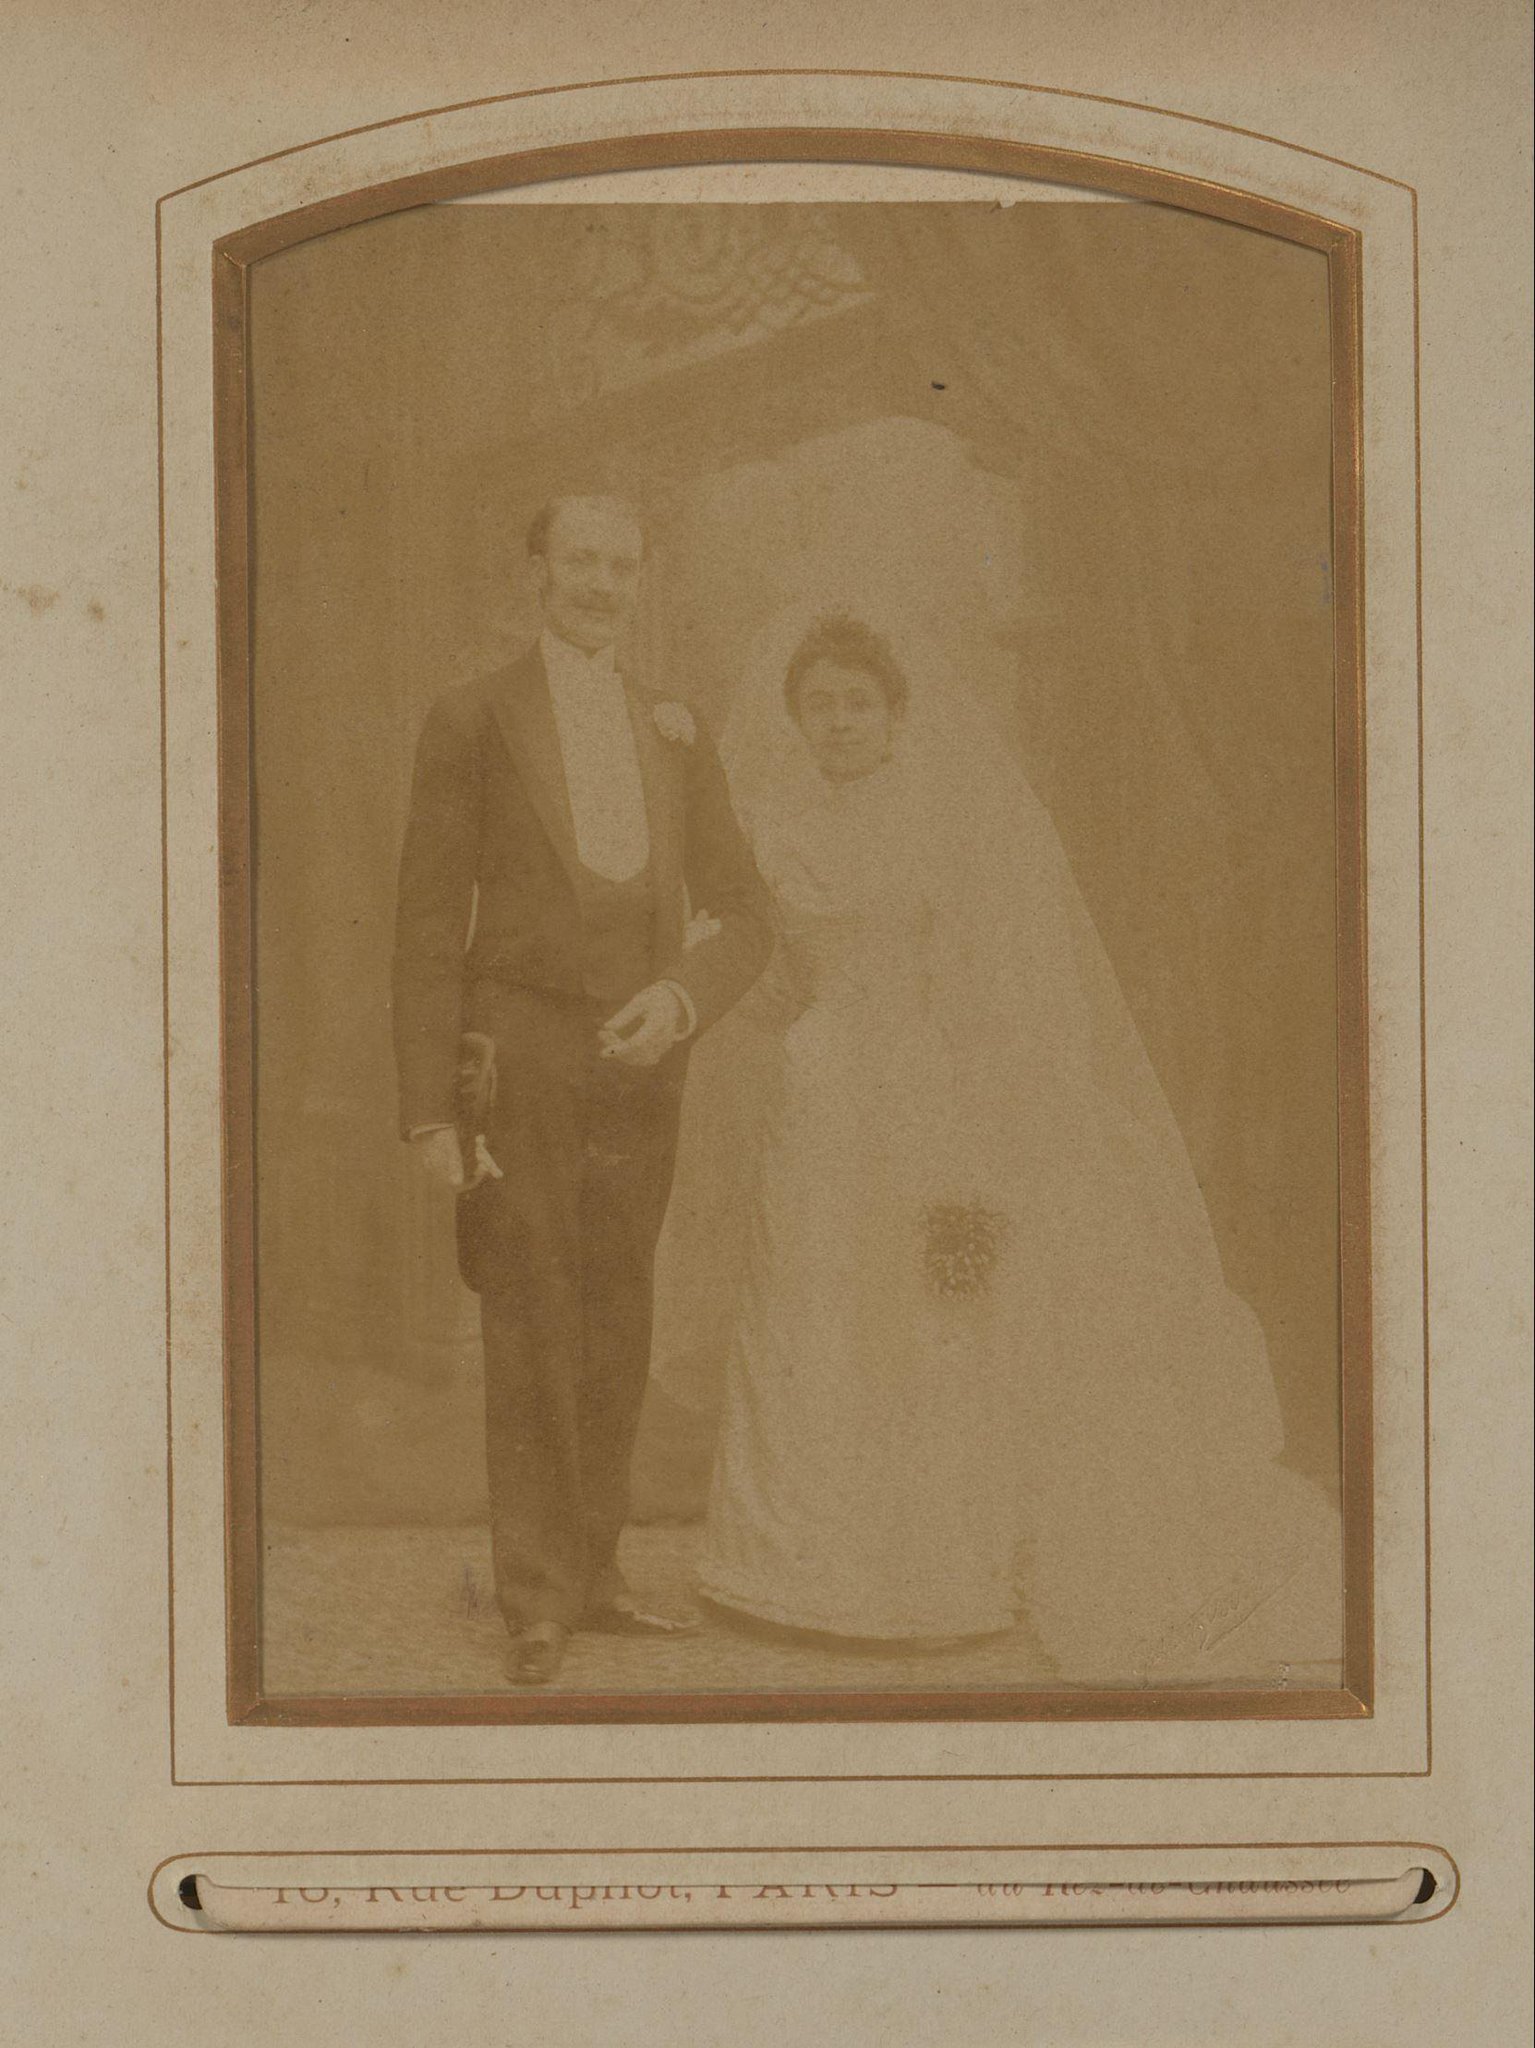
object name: album leaf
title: Portret van een echtpaar in bruidskleding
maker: gustave boscher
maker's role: fotograaf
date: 1860-1900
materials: cardboard, photographic support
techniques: albumen print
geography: paris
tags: bride and groom in wedding-dress, marriage, married couple, 'matrimonium'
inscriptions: name: ‘Gustave Boscher’, inscription: ‘Photographie d'Art/ et hippique/ Instantanés - Reproductions, &a/ BOSCHER/ Artiste-Peintre/ Récompenses à toutes les Expositions/ 16, Rue Duphot, 16/ près le Bould de la Madeleine/ AU/ REZ-DE-CHAUSSÉE/ JARDIN/ Leçons & Fournitures aux Amateurs/ PRIX MODÉRÉS/ Lec Clichés sont conservés’